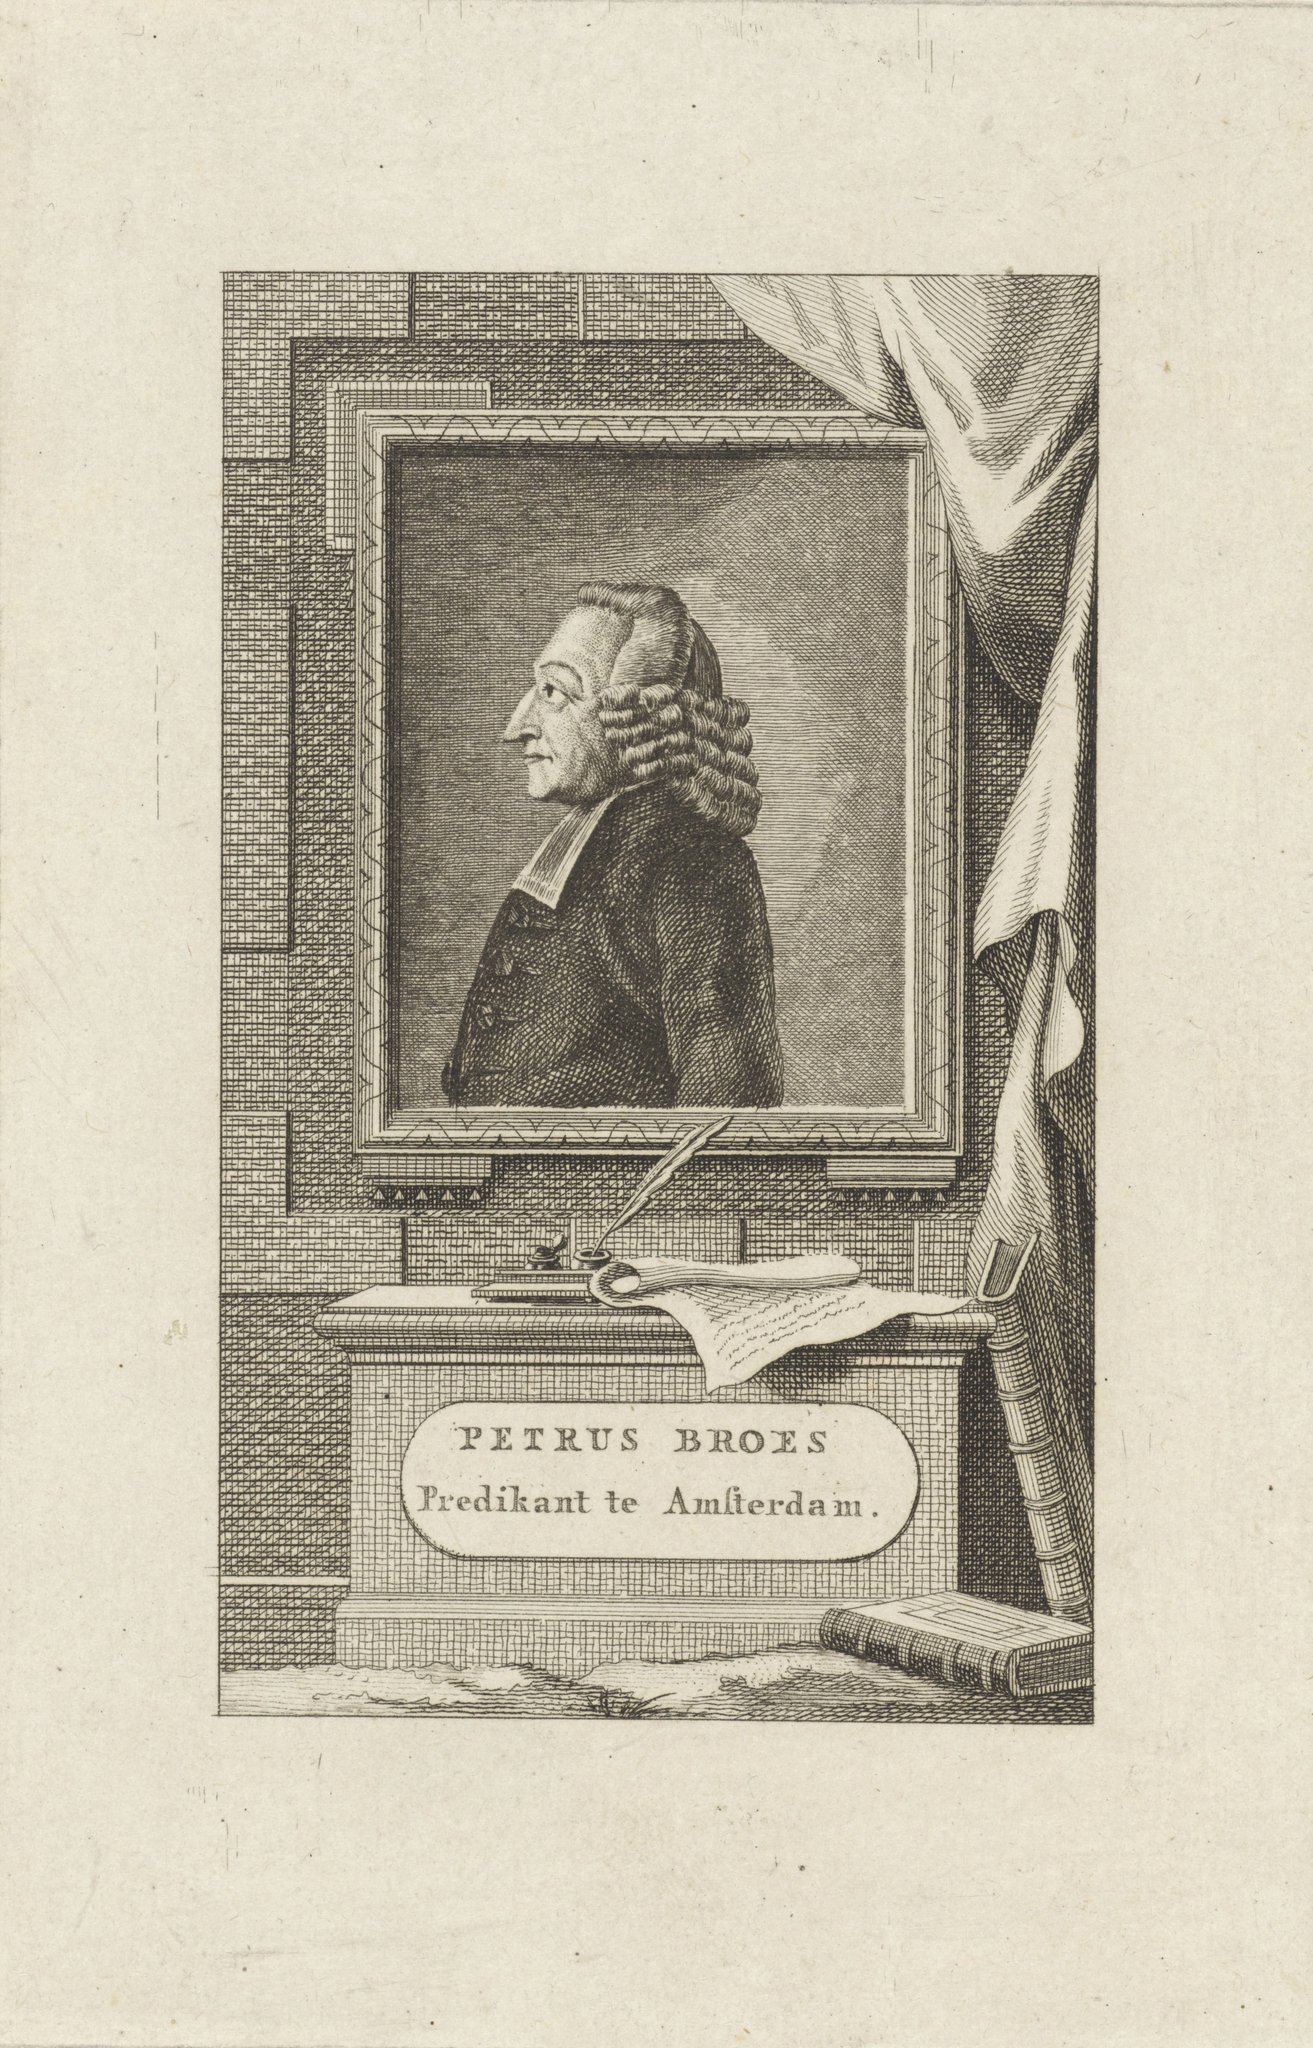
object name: print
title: Portret van de Amsterdamse predikant Petrus Broes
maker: reinier vinkeles (i)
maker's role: draughtsman, print maker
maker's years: 1741-1816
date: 1770-1816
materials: paper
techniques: engraving, etching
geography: amsterdam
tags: petrus broes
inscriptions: collector's mark: Lugt 2228